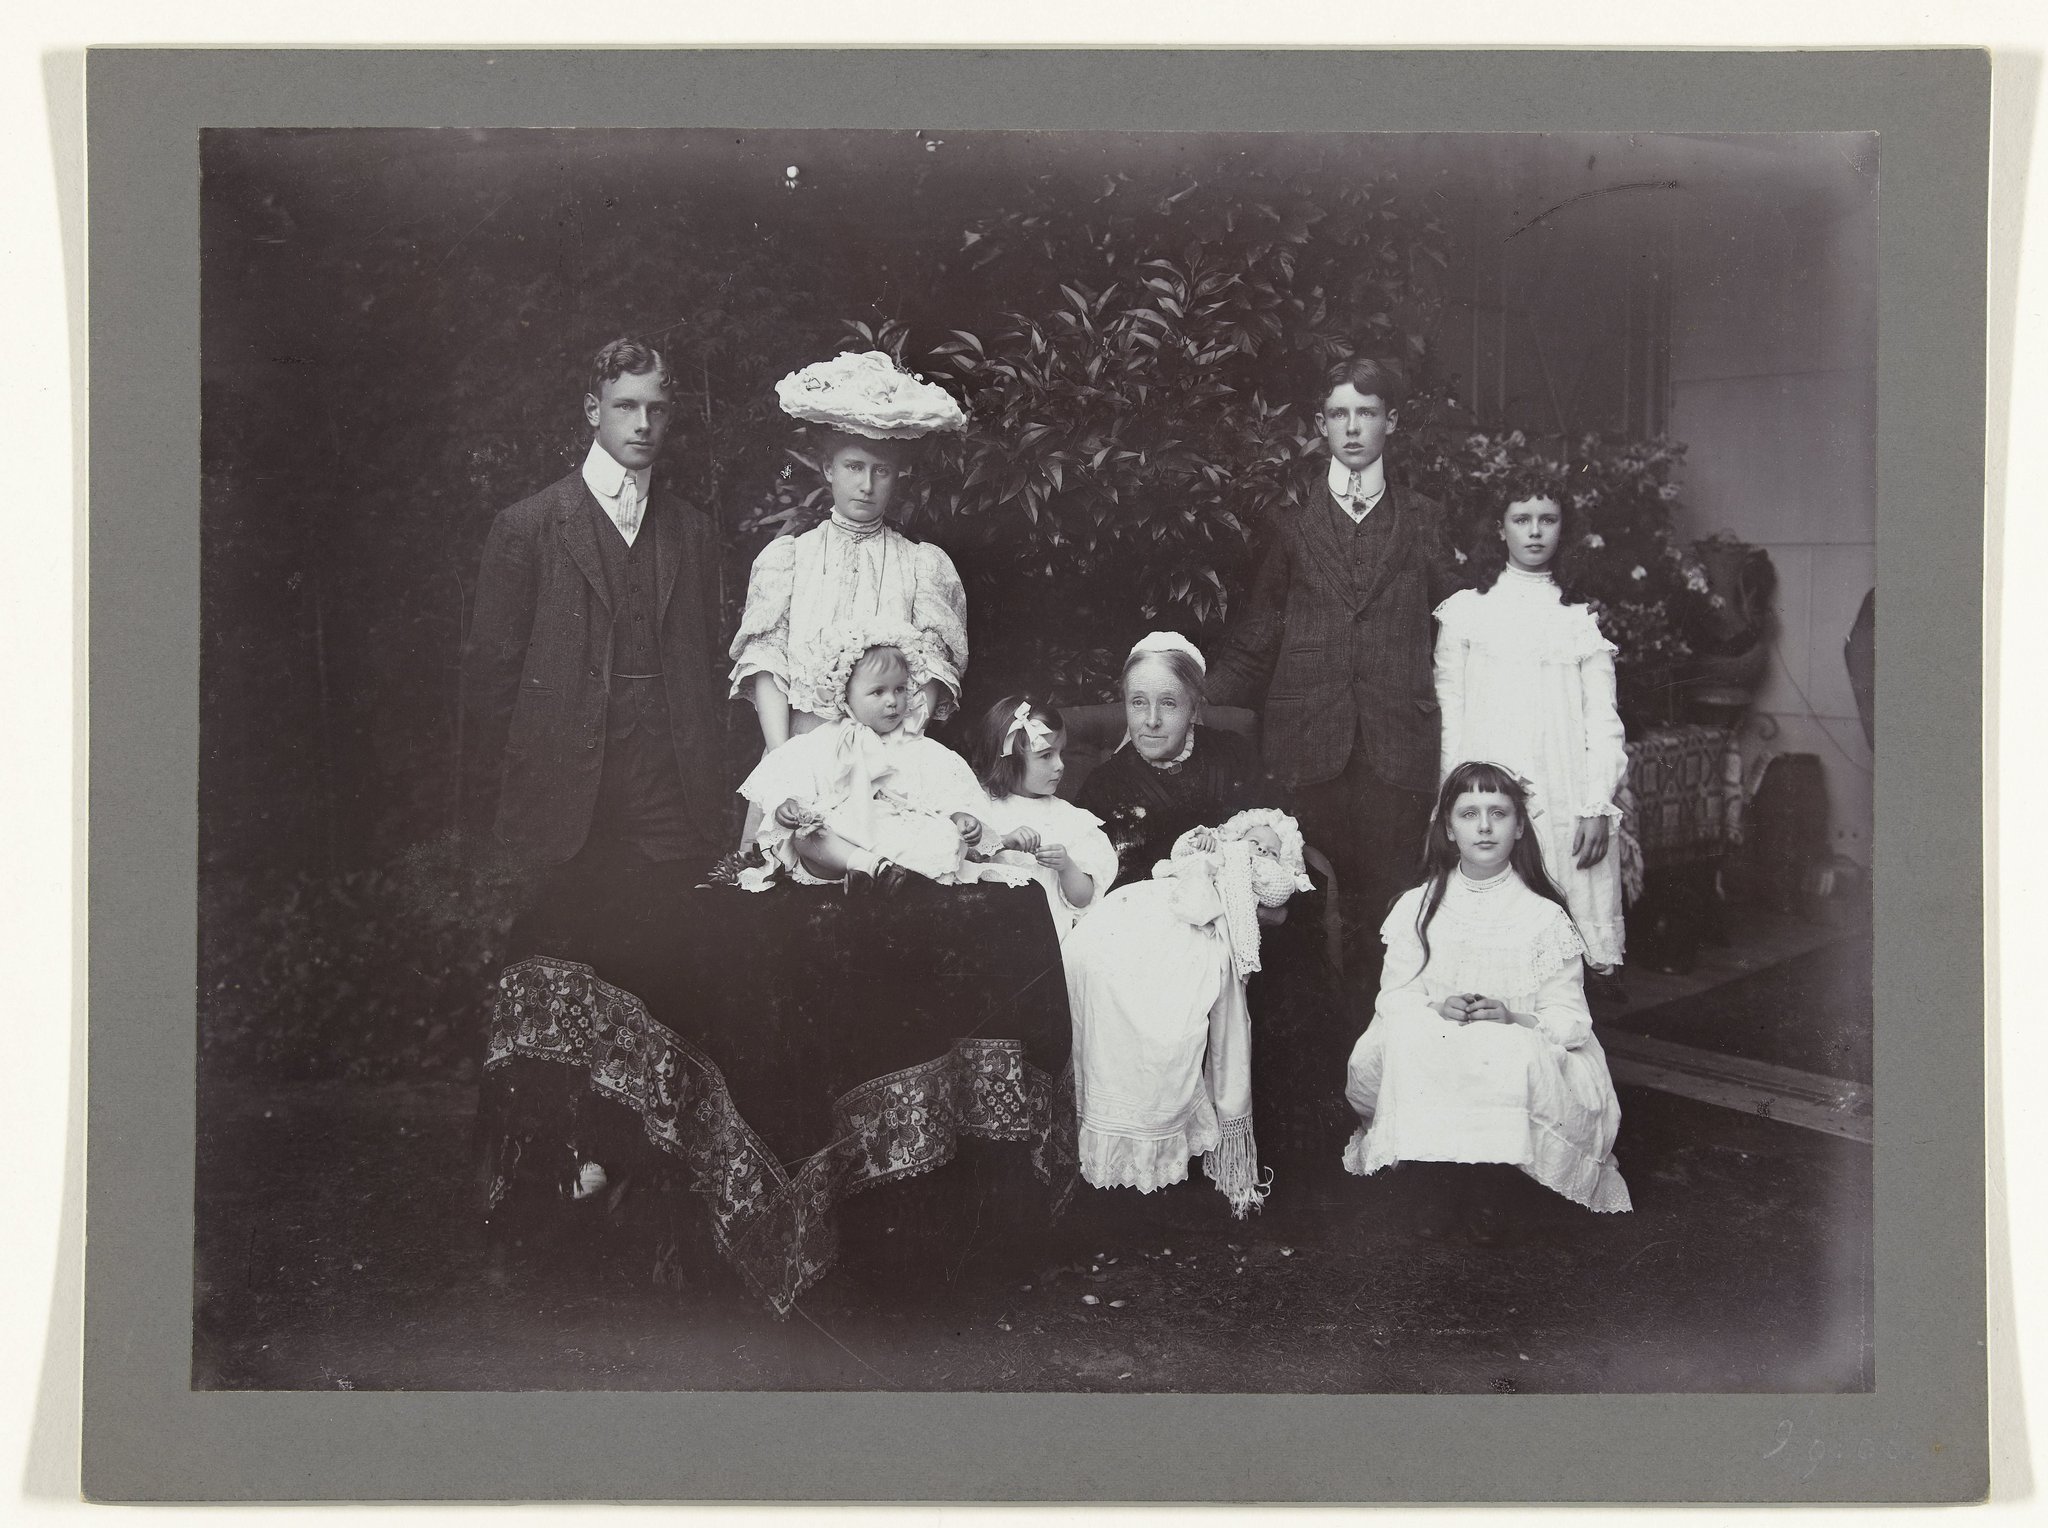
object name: photograph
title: Groepsportret van negen personen, onder wie Aletta Cornelia Anna Voombergh (1828-1913), de moeder van de fotograaf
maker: henry pauw van wieldrecht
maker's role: fotograaf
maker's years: 1863-1912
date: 1906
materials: cardboard, photographic support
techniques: gelatin silver print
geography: netherlands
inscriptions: annotation: ‘No 3100. ['4000' doorgehaald]. / 1906.’, annotation: ‘Iman Schimmelpenninck / Evia [?] Schimmelpenninck / Annie Schimmelpenninck / Renée Schimmelpenninck / Rut [?] Schimmelpenninck / Sacha / Renée / Irene / Granny [in potlood: 78 jaar]’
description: Iman Schimmelpenninck, Evia [?] Schimmelpenninck, Annie Schimmelpenninck [= Adriana Schimmelpenninck-Pauw van Wieldrecht, jongere zuster van de fotograaf?], Renée Schimmelpenninck, Rut [?] Schimmelpenninck [= Rutger Jan, echtgenote van Adriana Schimmelpenninck-Pauw van Wieldrecht?], Sacha Pauw van Wieldrecht, Renée Pauw van Wieldrecht en Irene Pauw van Wieldrecht.